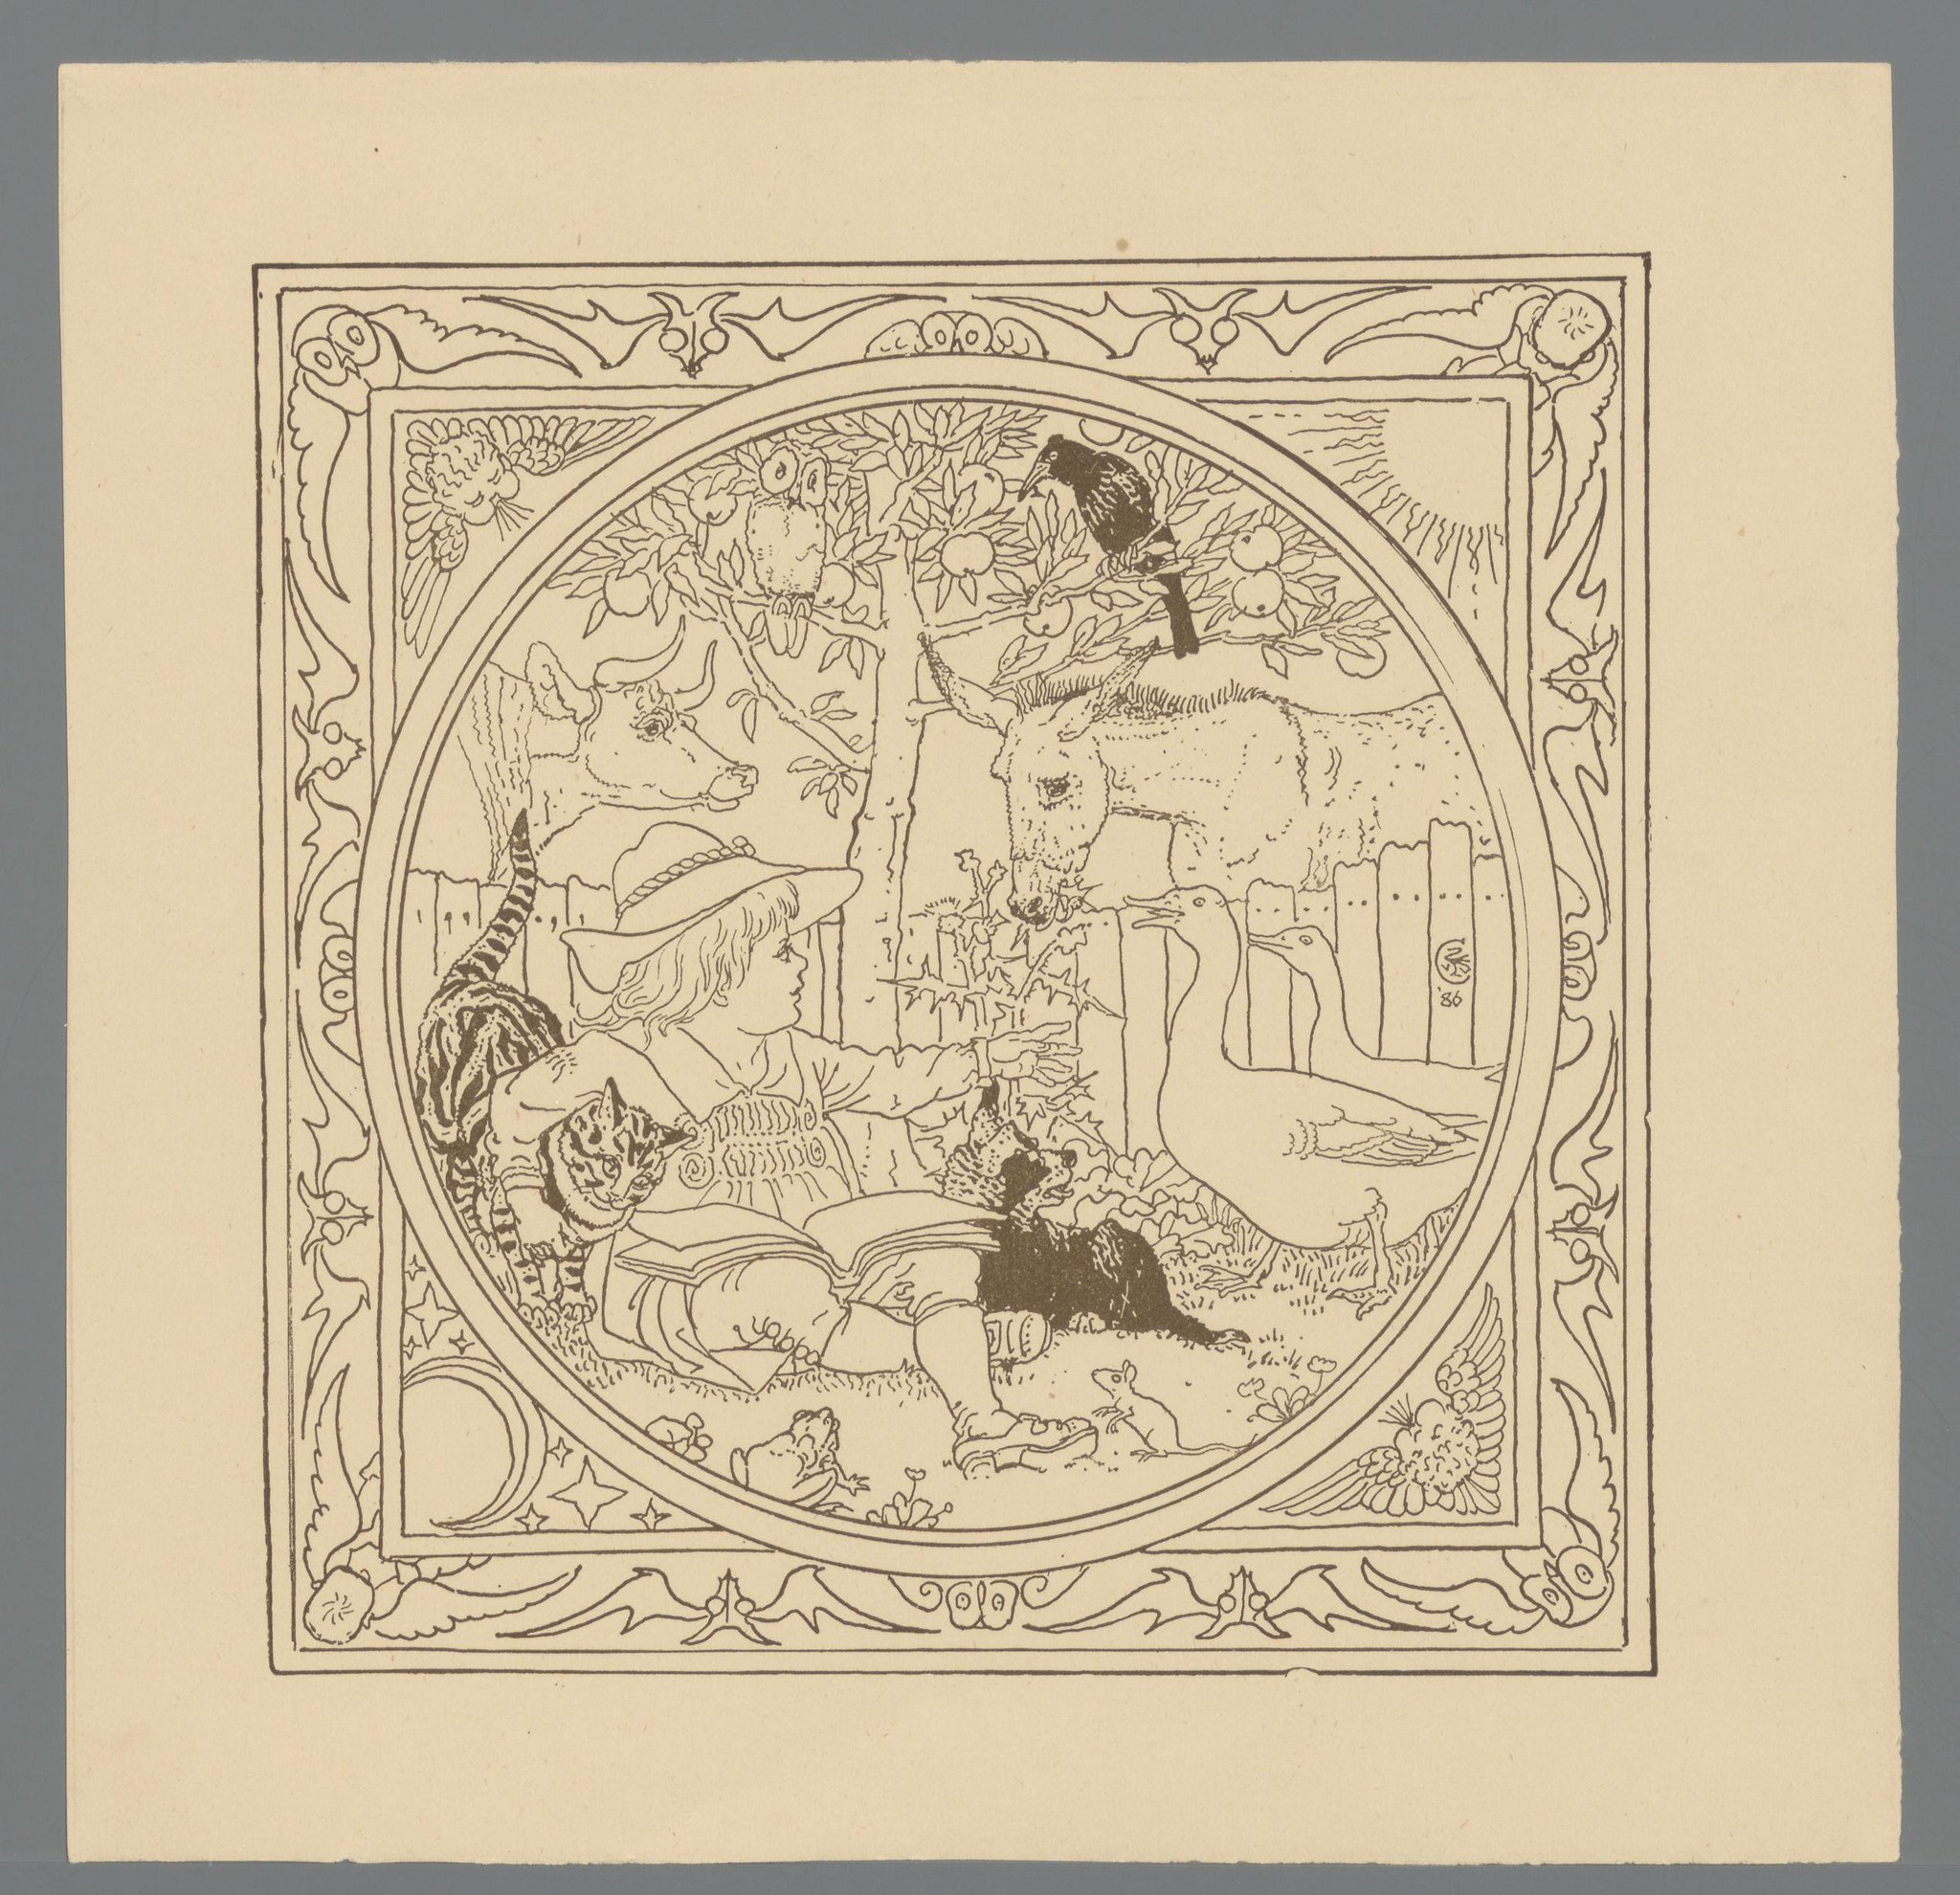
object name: print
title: Jongen in een tuin met dieren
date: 1887-1927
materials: paper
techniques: engraving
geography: london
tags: animals, garden, tot, toddler ~ the ages of man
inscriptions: collector's mark: Lugt 2228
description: Prent uit: Walter Crane's painting book. Londen: Routledge & Sons, 1887. Of een latere uitgave. Dit boek bevat twaalf voorstellingen die in kleur en lijntekening zijn gedrukt om te gebruiken als (in)kleurboek. De voorstellingen zijn afkomstig uit eerdere werken van Crane.